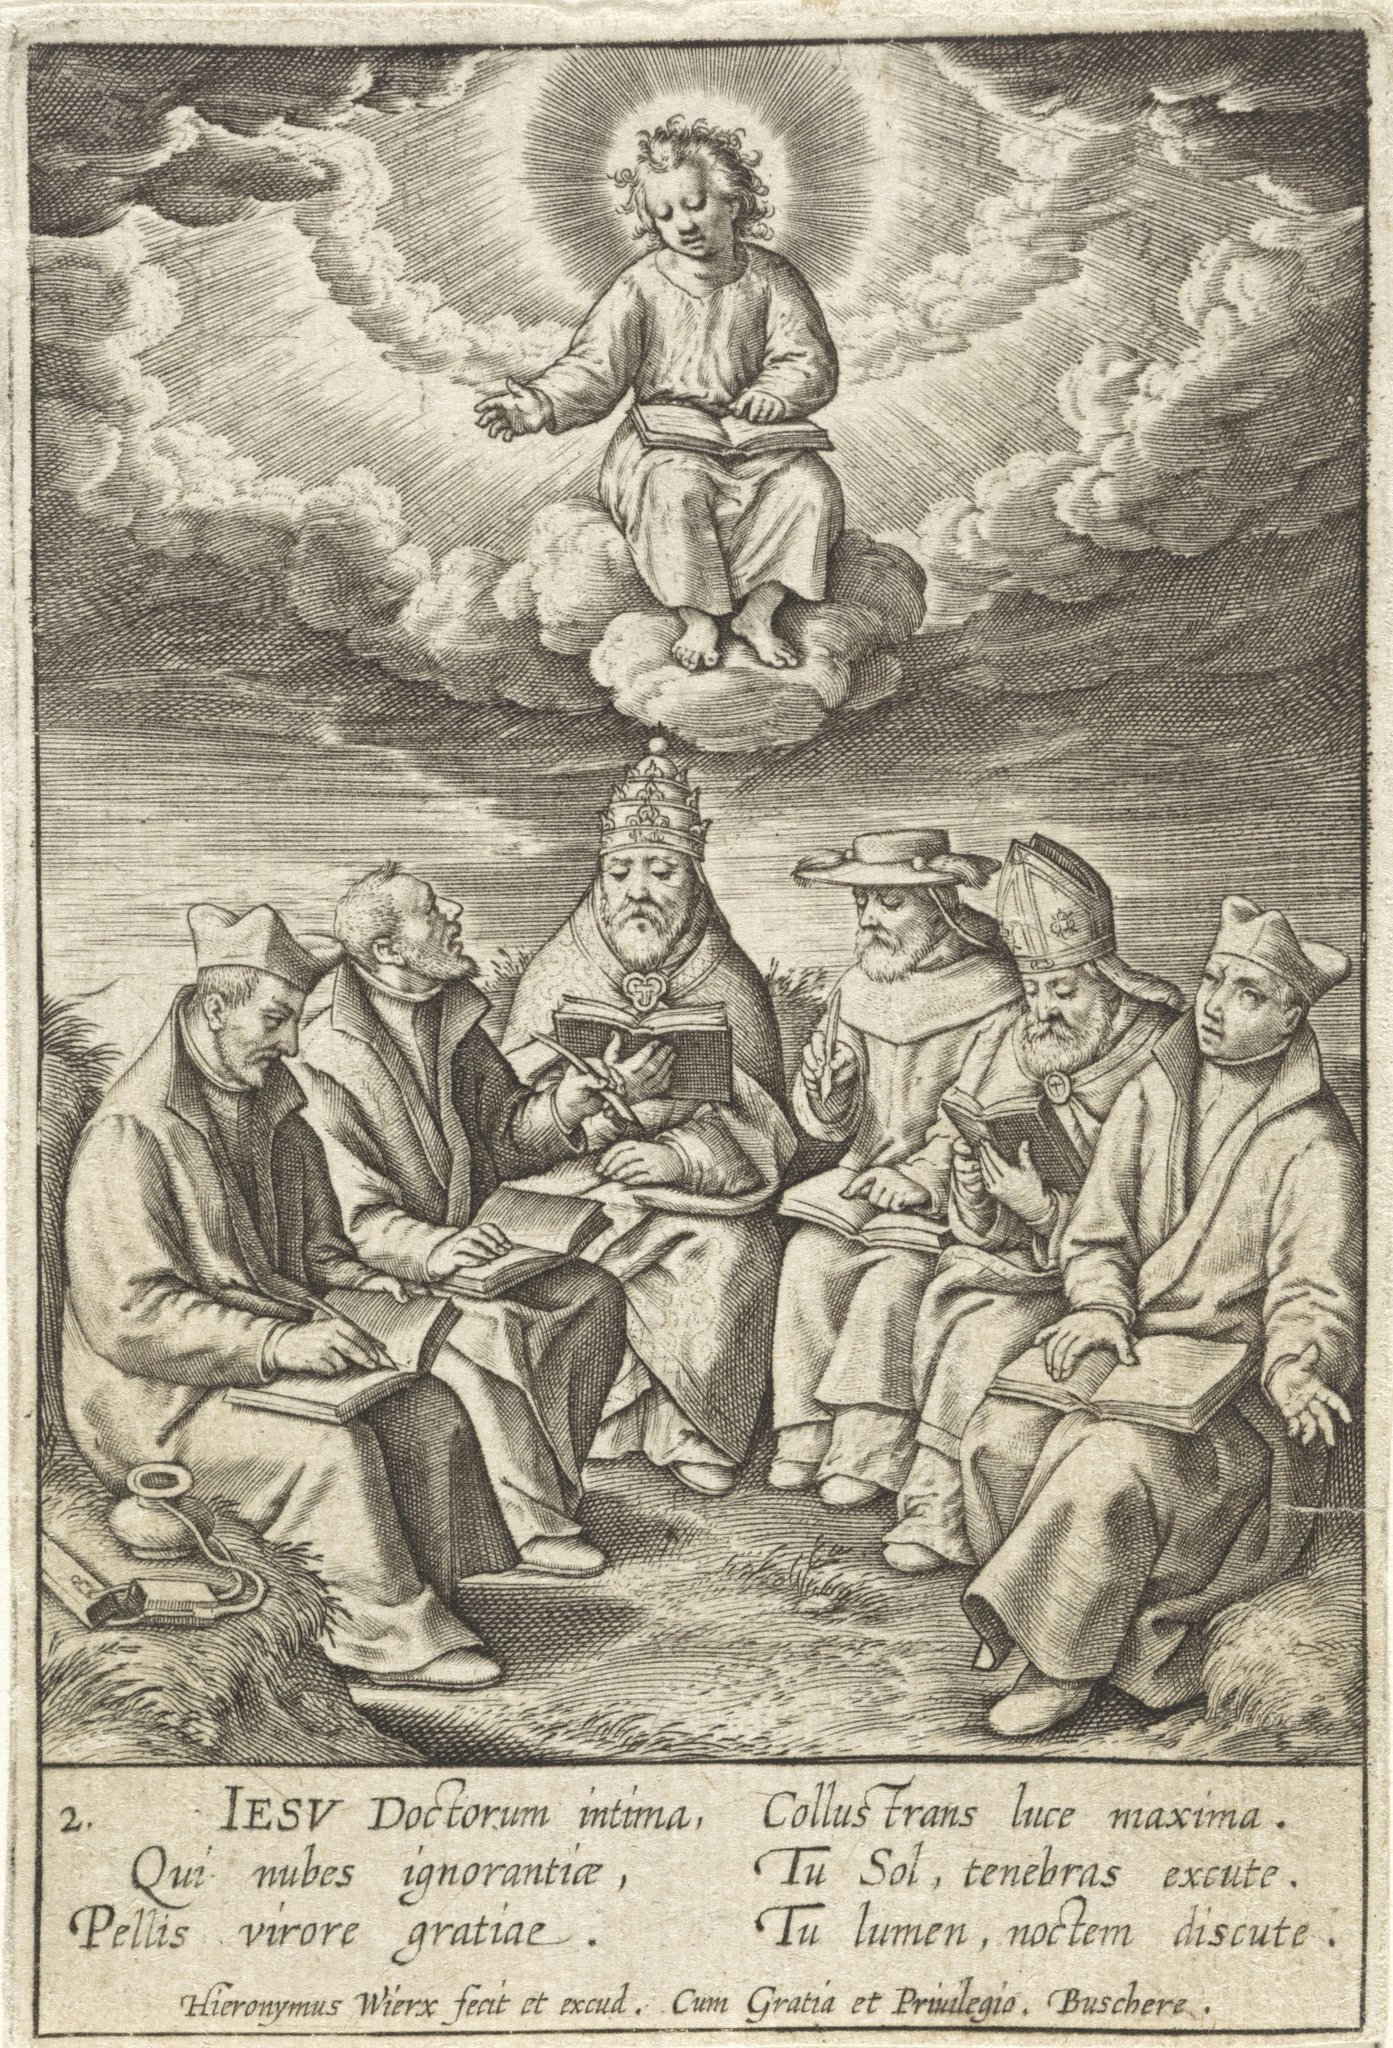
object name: print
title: Aanbidding van het Christuskind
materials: paper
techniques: engraving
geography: antwerp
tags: christ-child (with attributes), organization, functionaries and dignitaries in roman catholic church; clergy in general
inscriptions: collector's mark: Lugt 2228, inscription: ‘Landsberg 1770 [...]’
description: Zes geestelijken aanbidden het Christuskind dat hen zegent vanaf een wolk. Het gezelschap bestaat uit een paus, een kardinaal, een bisschop en drie Jezuïeten. In de marge een zesregelig onderschrift, in twee kolommen, in het Latijn.